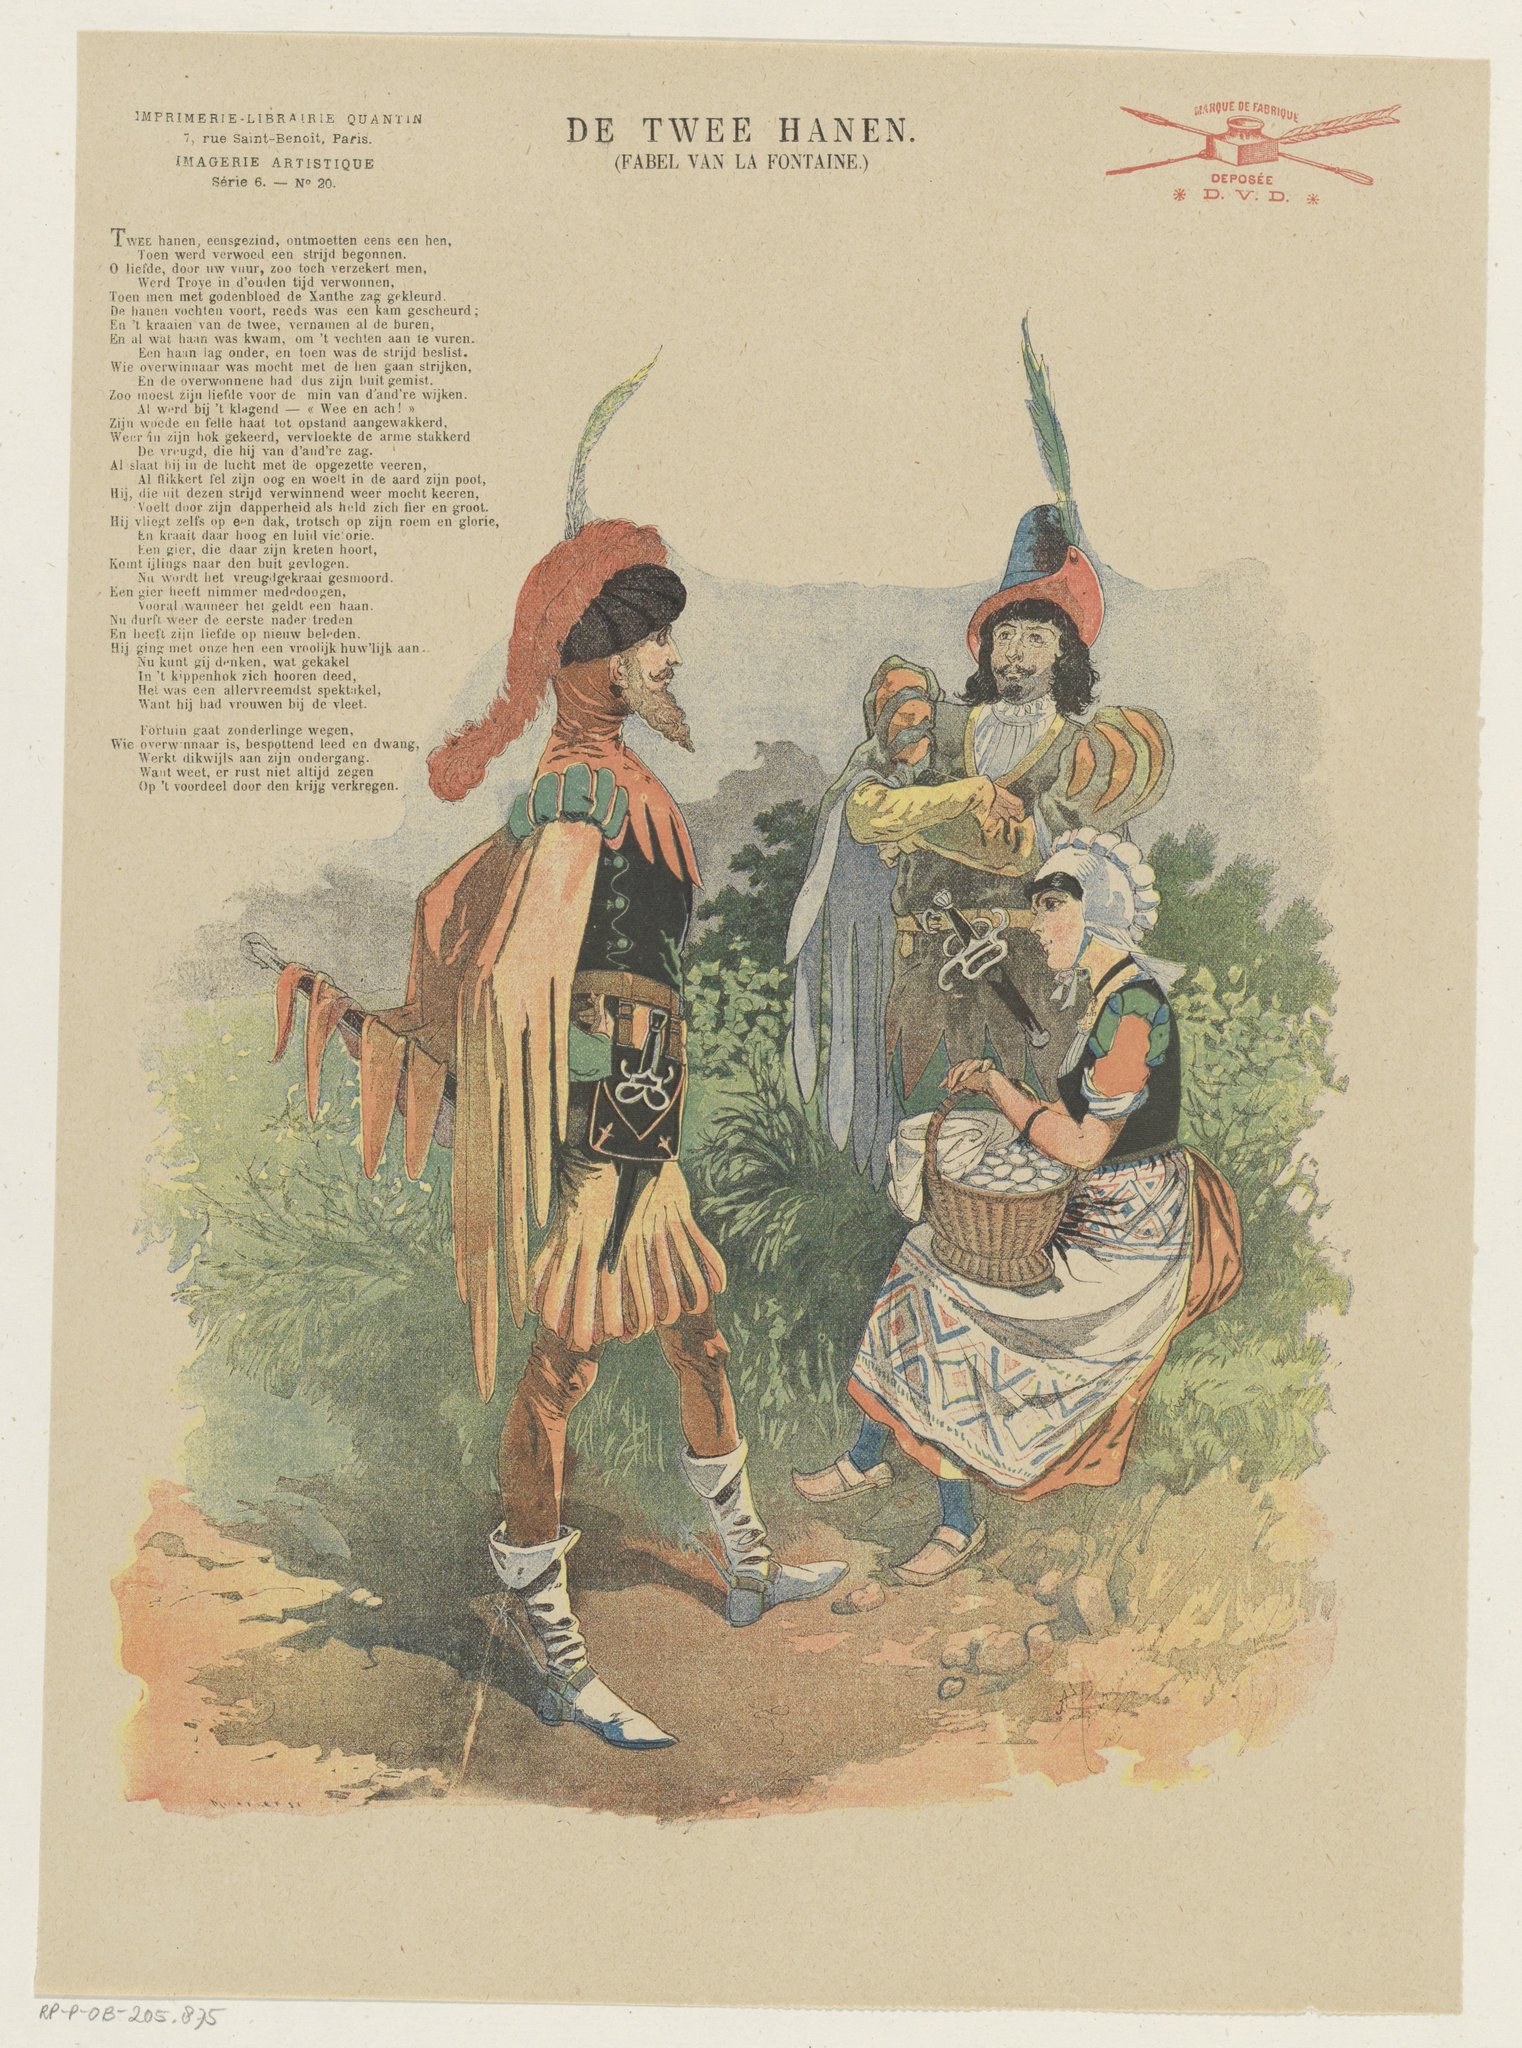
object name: popular print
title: De twee hanen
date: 1876-1890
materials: paper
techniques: lithograph, letterpress printing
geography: paris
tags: fables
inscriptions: collector's mark: Lugt 2760, : ‘marque de fabrique / deposée / * D.V.D. *’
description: Blad met een grote voorstelling uit de fabel van Jean de La Fontaine, van de twee hanen. linksboven een vers. Genummerd linksboven: Série 6. - No. 20.